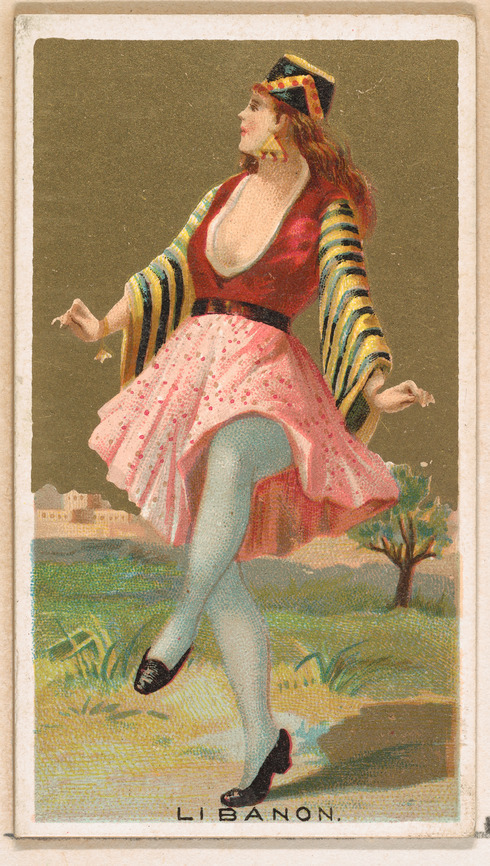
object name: print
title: Libanon, from the Dancing Girls of the World series (N185) issued by Wm. S. Kimball & Co.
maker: william s. kimball & company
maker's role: publisher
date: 1889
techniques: color lithograph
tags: profiles,women,dancing,dancers